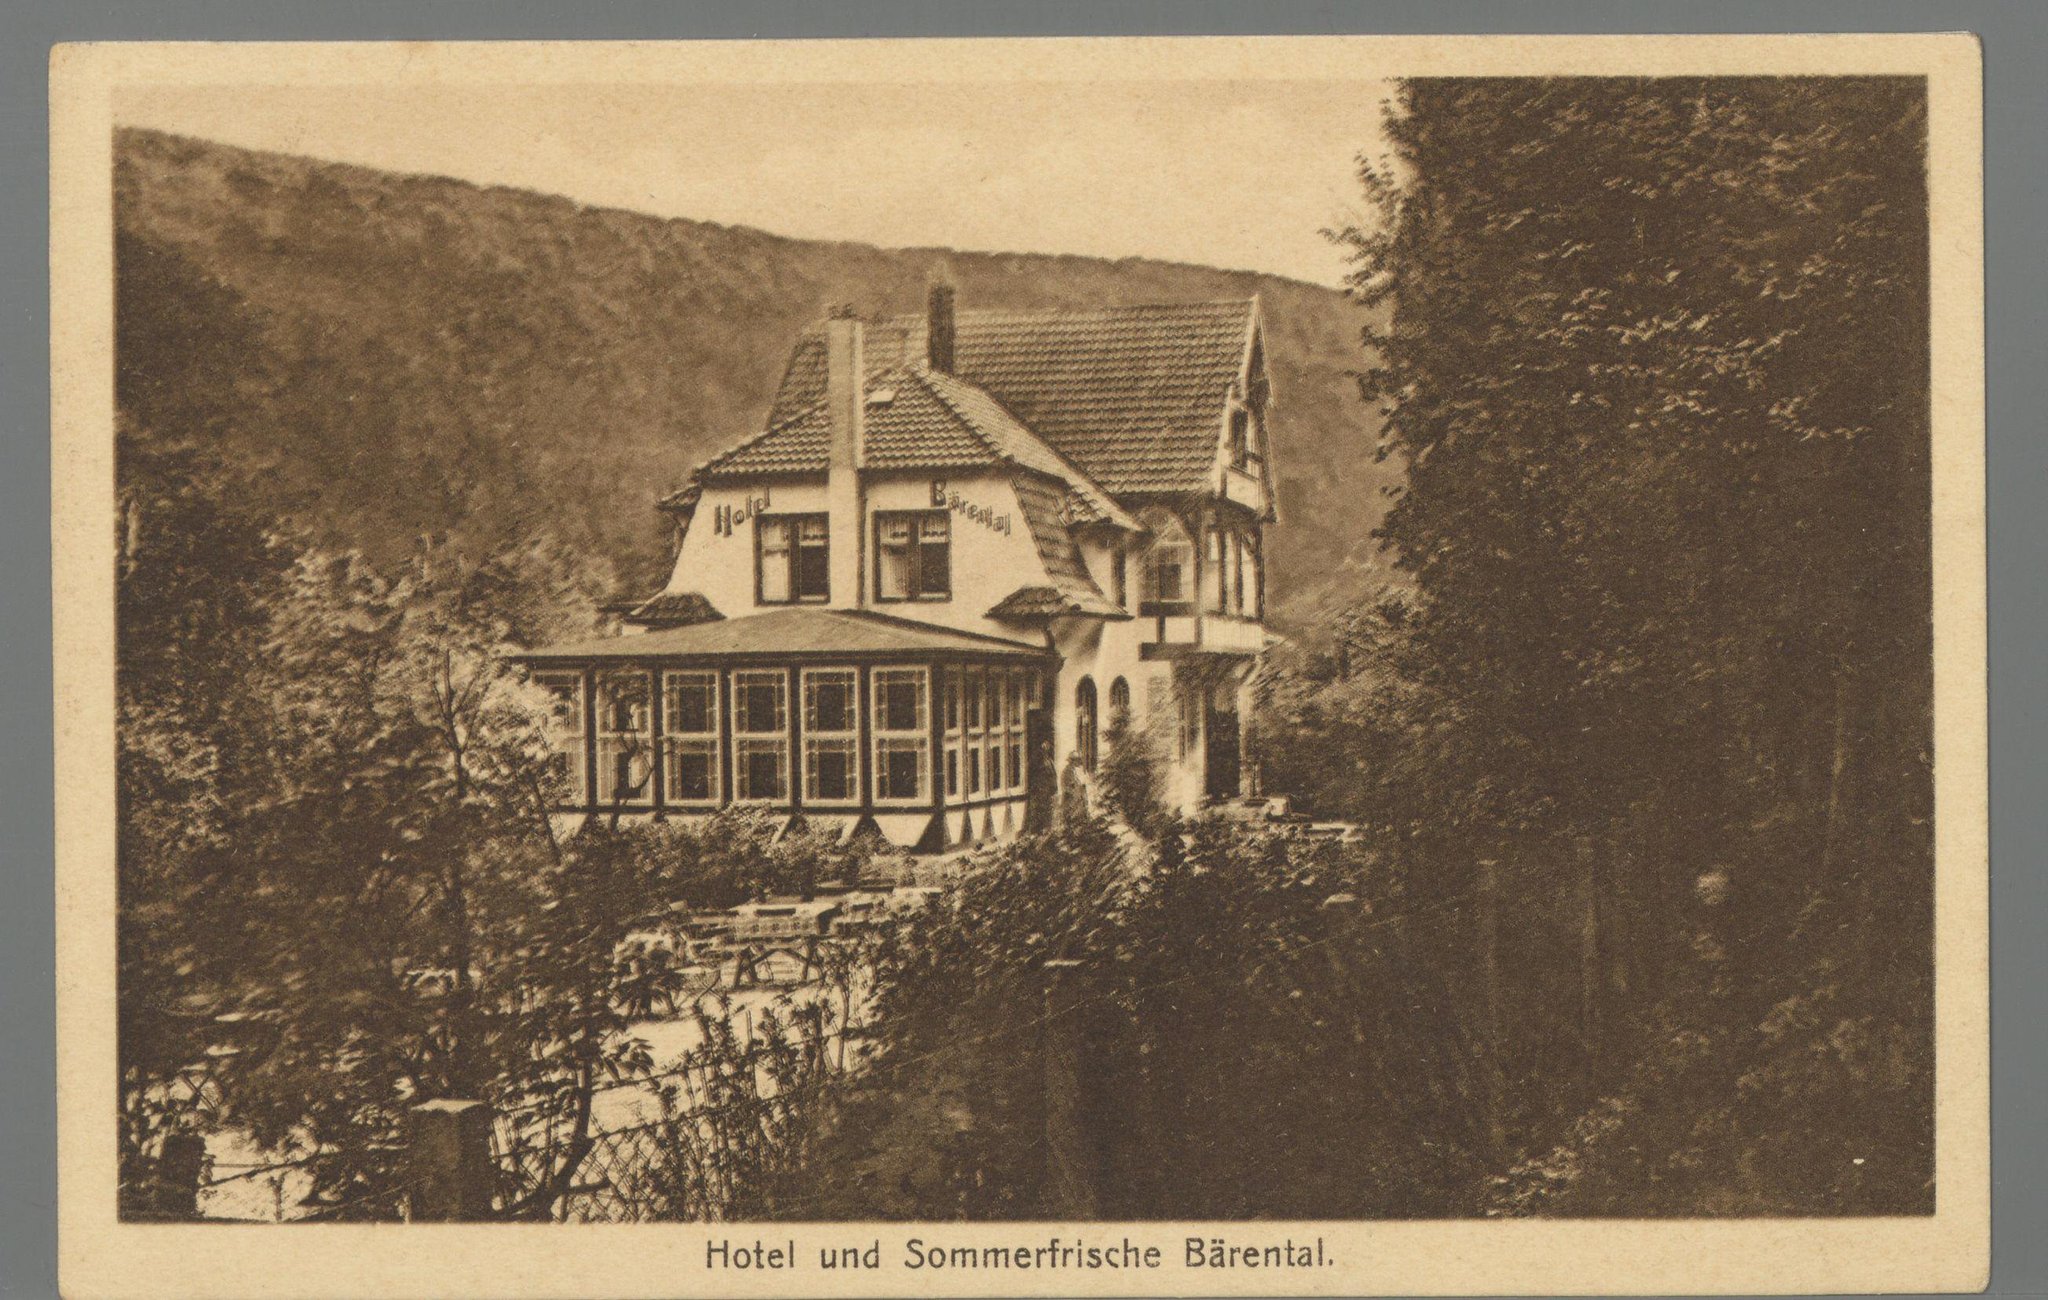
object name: photomechanical print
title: Hotel und Sommerfrische Bärental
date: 1905-1930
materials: cardboard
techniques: photograph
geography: teutoburgerwoud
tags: forest, wood, restaurant